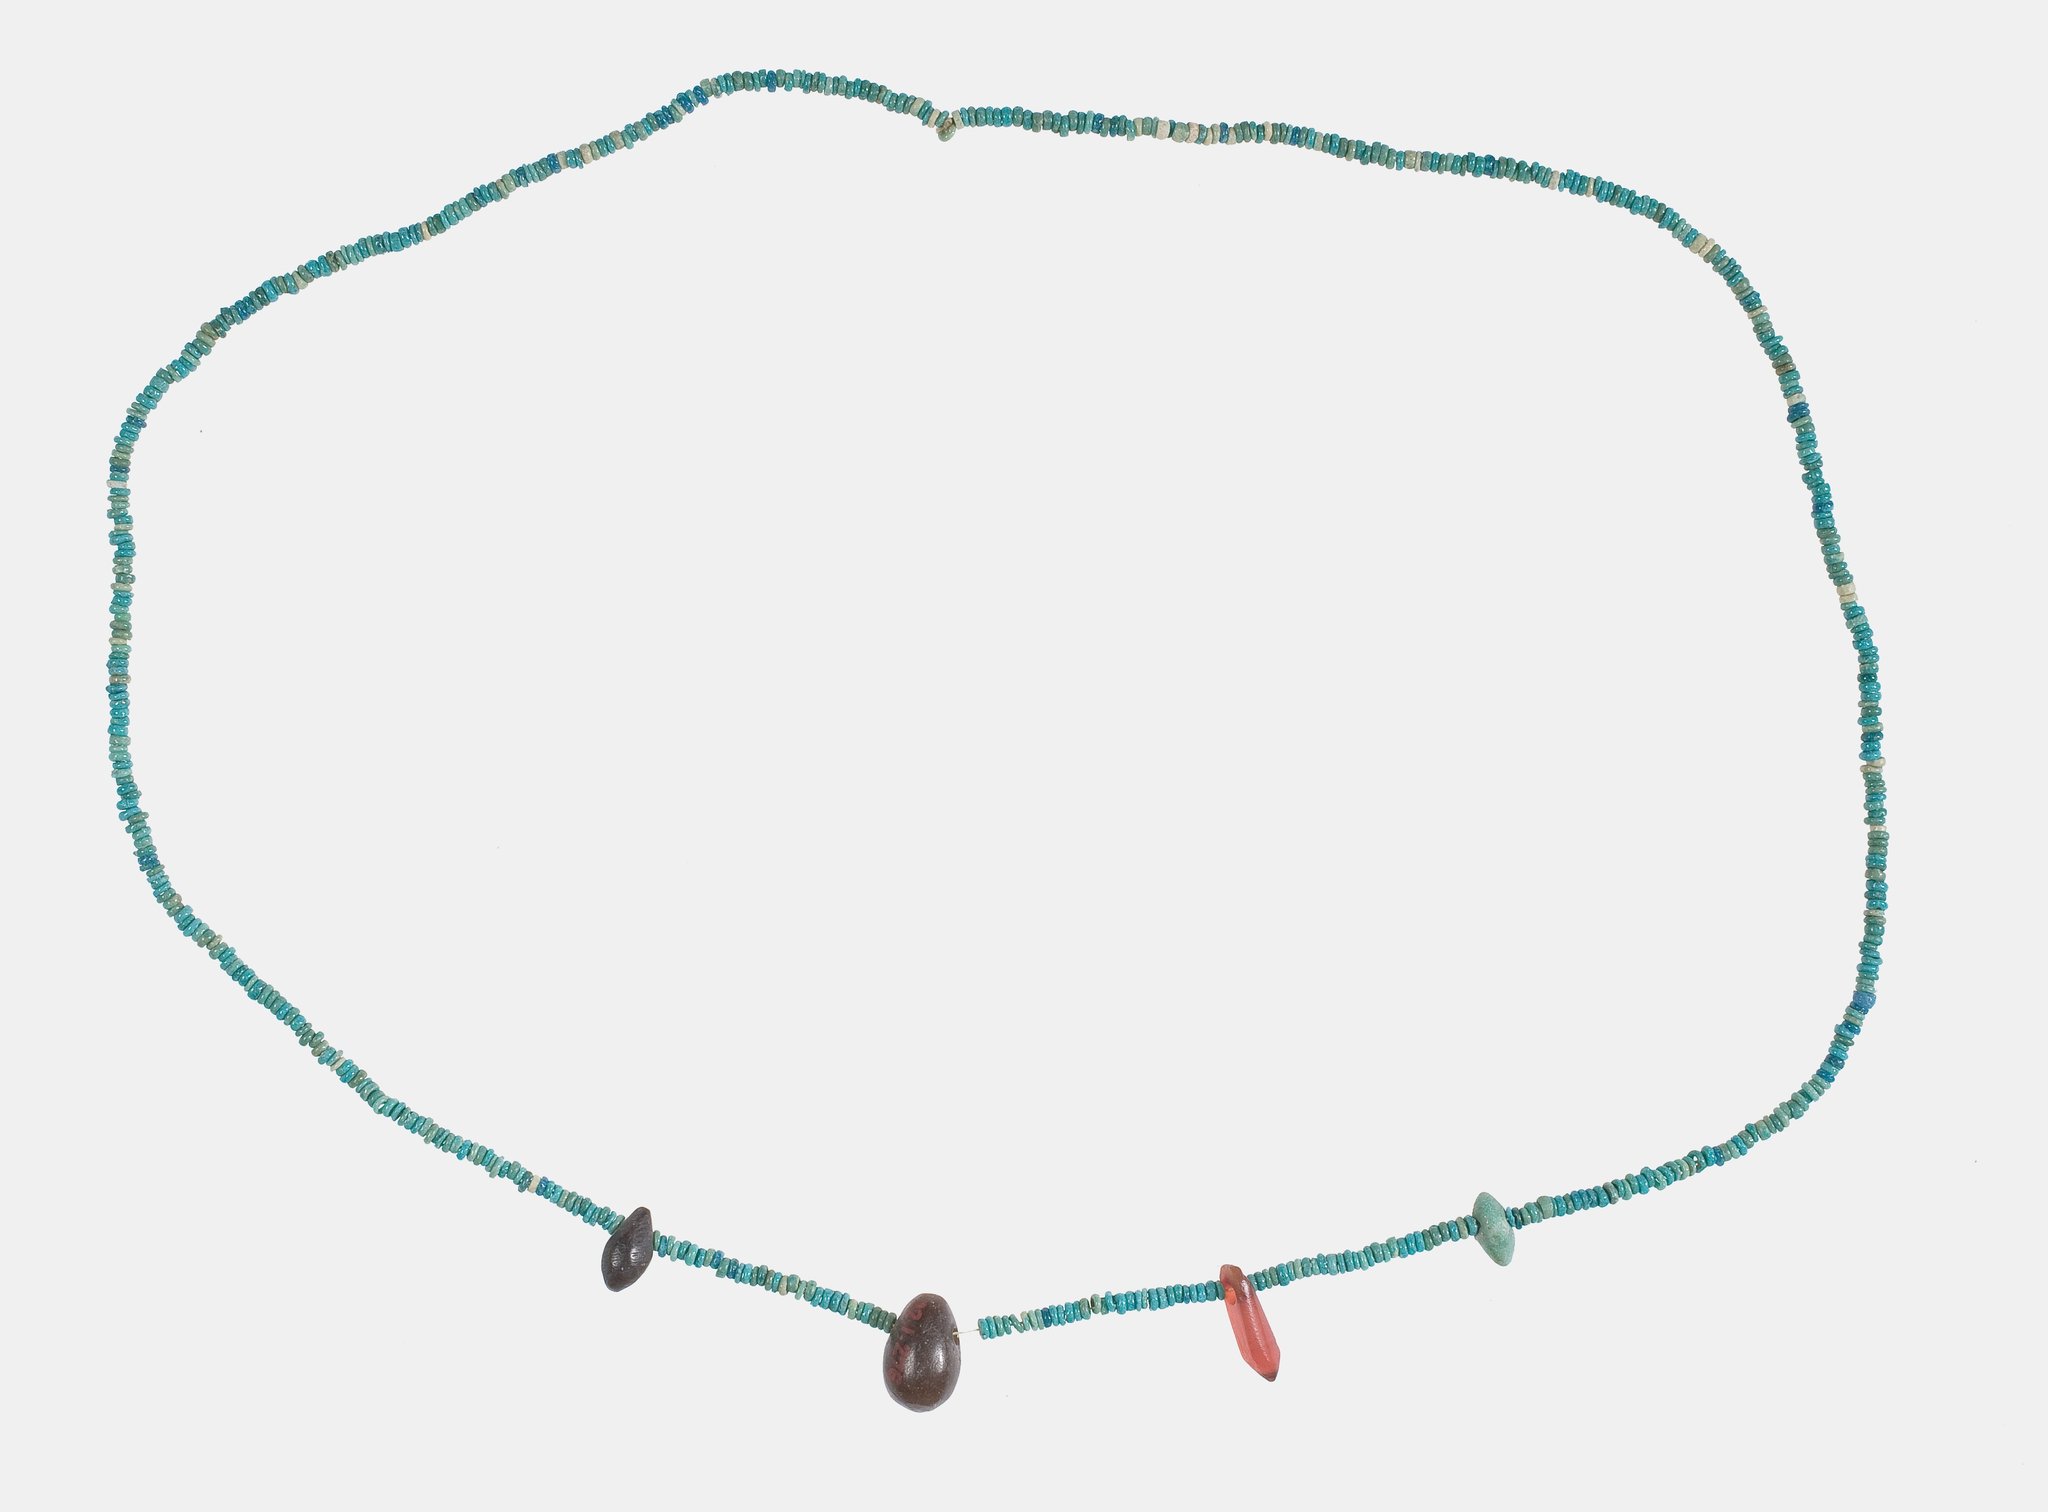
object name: pendant jewelry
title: Necklace with pendants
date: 1700-1550 BCE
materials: gemstone, faience, mineral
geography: egypt